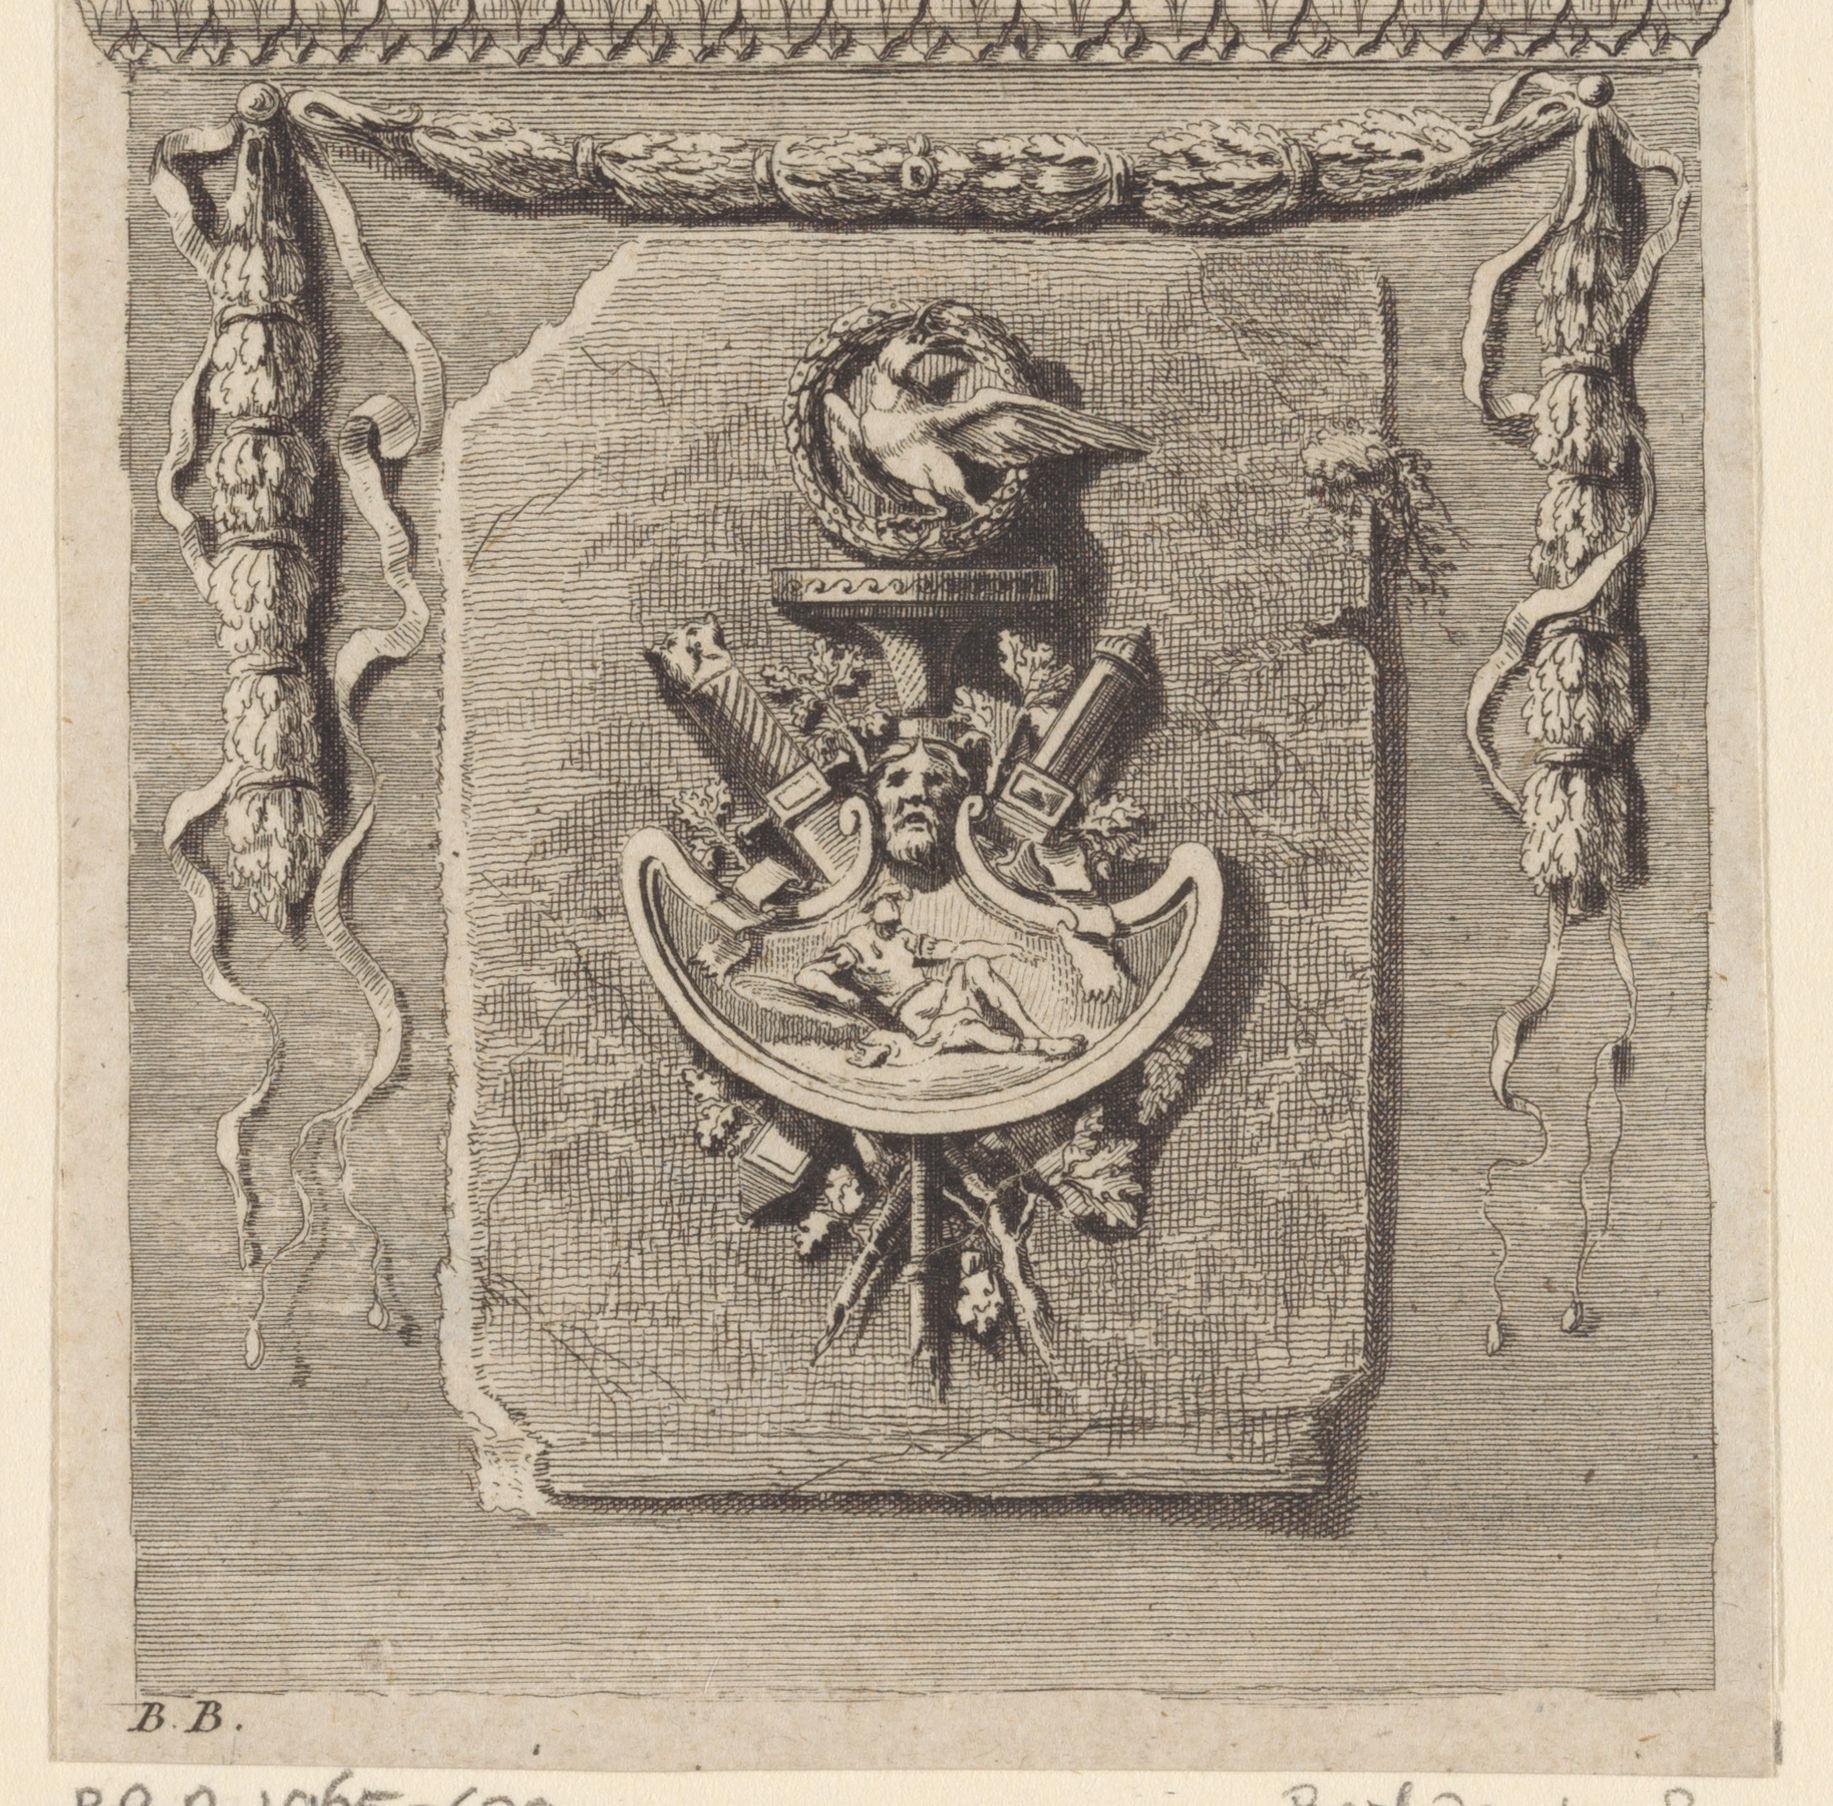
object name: ornament print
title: Trofee met guirlande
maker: benigno bossi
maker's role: print maker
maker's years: 1727-1792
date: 1737-1792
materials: paper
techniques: etching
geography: italy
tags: ornaments ~ art, ornament ~ festoon, garland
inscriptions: collector's mark: Lugt 2760, collector's mark: Lugt 2228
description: Prent maakt deel uit van een reeks ornamentprenten.